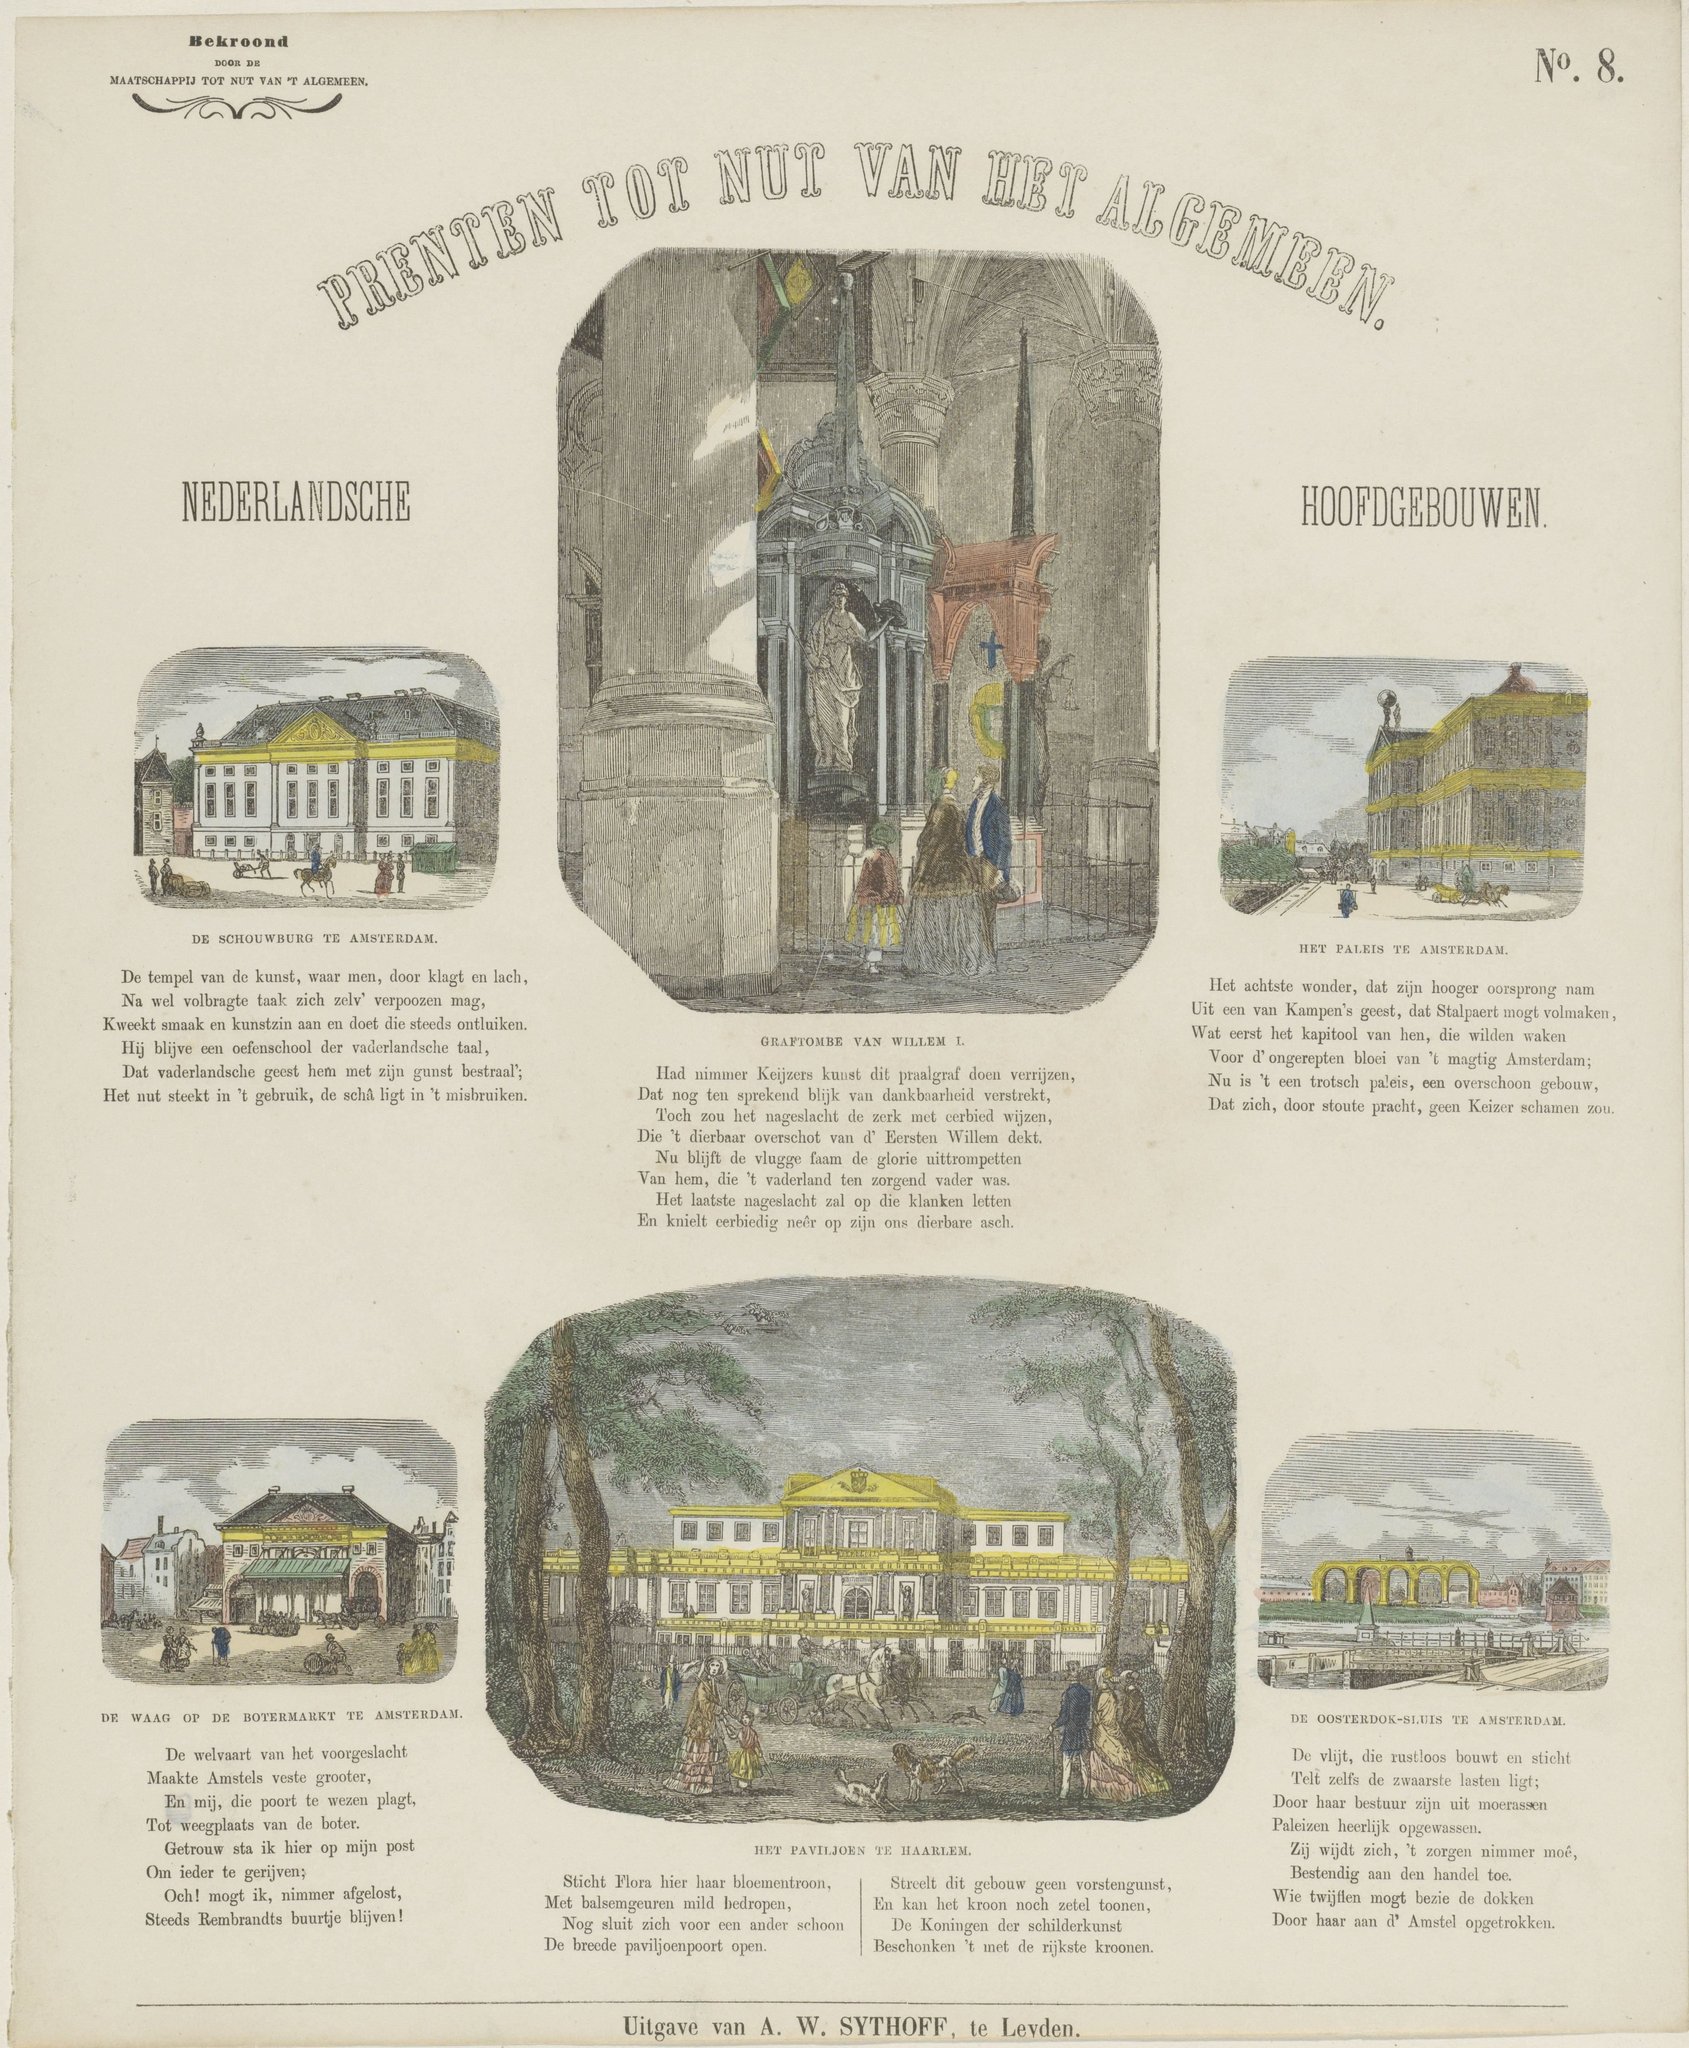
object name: print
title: Prenten tot nut van het algemeen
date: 1861-1929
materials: paper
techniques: colour, letterpress printing, engraving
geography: europe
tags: berlin, william i of the netherlands, palace, theatre (building), haarlem, royal palace of amsterdam, amsterdam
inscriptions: collector's mark: Lugt 2760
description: Blad met 6 voorstellingen van gebouwen en monumenten in Nederland, zoals de Schouwburg in Amsterdam en het grafmonument van Willem I. Onder elke voorstelling een titel en een vers. Genummerd rechtsboven: No. 8. Linksboven: Bekroond door de Maatschappij tot Nut van 't Algemeen.